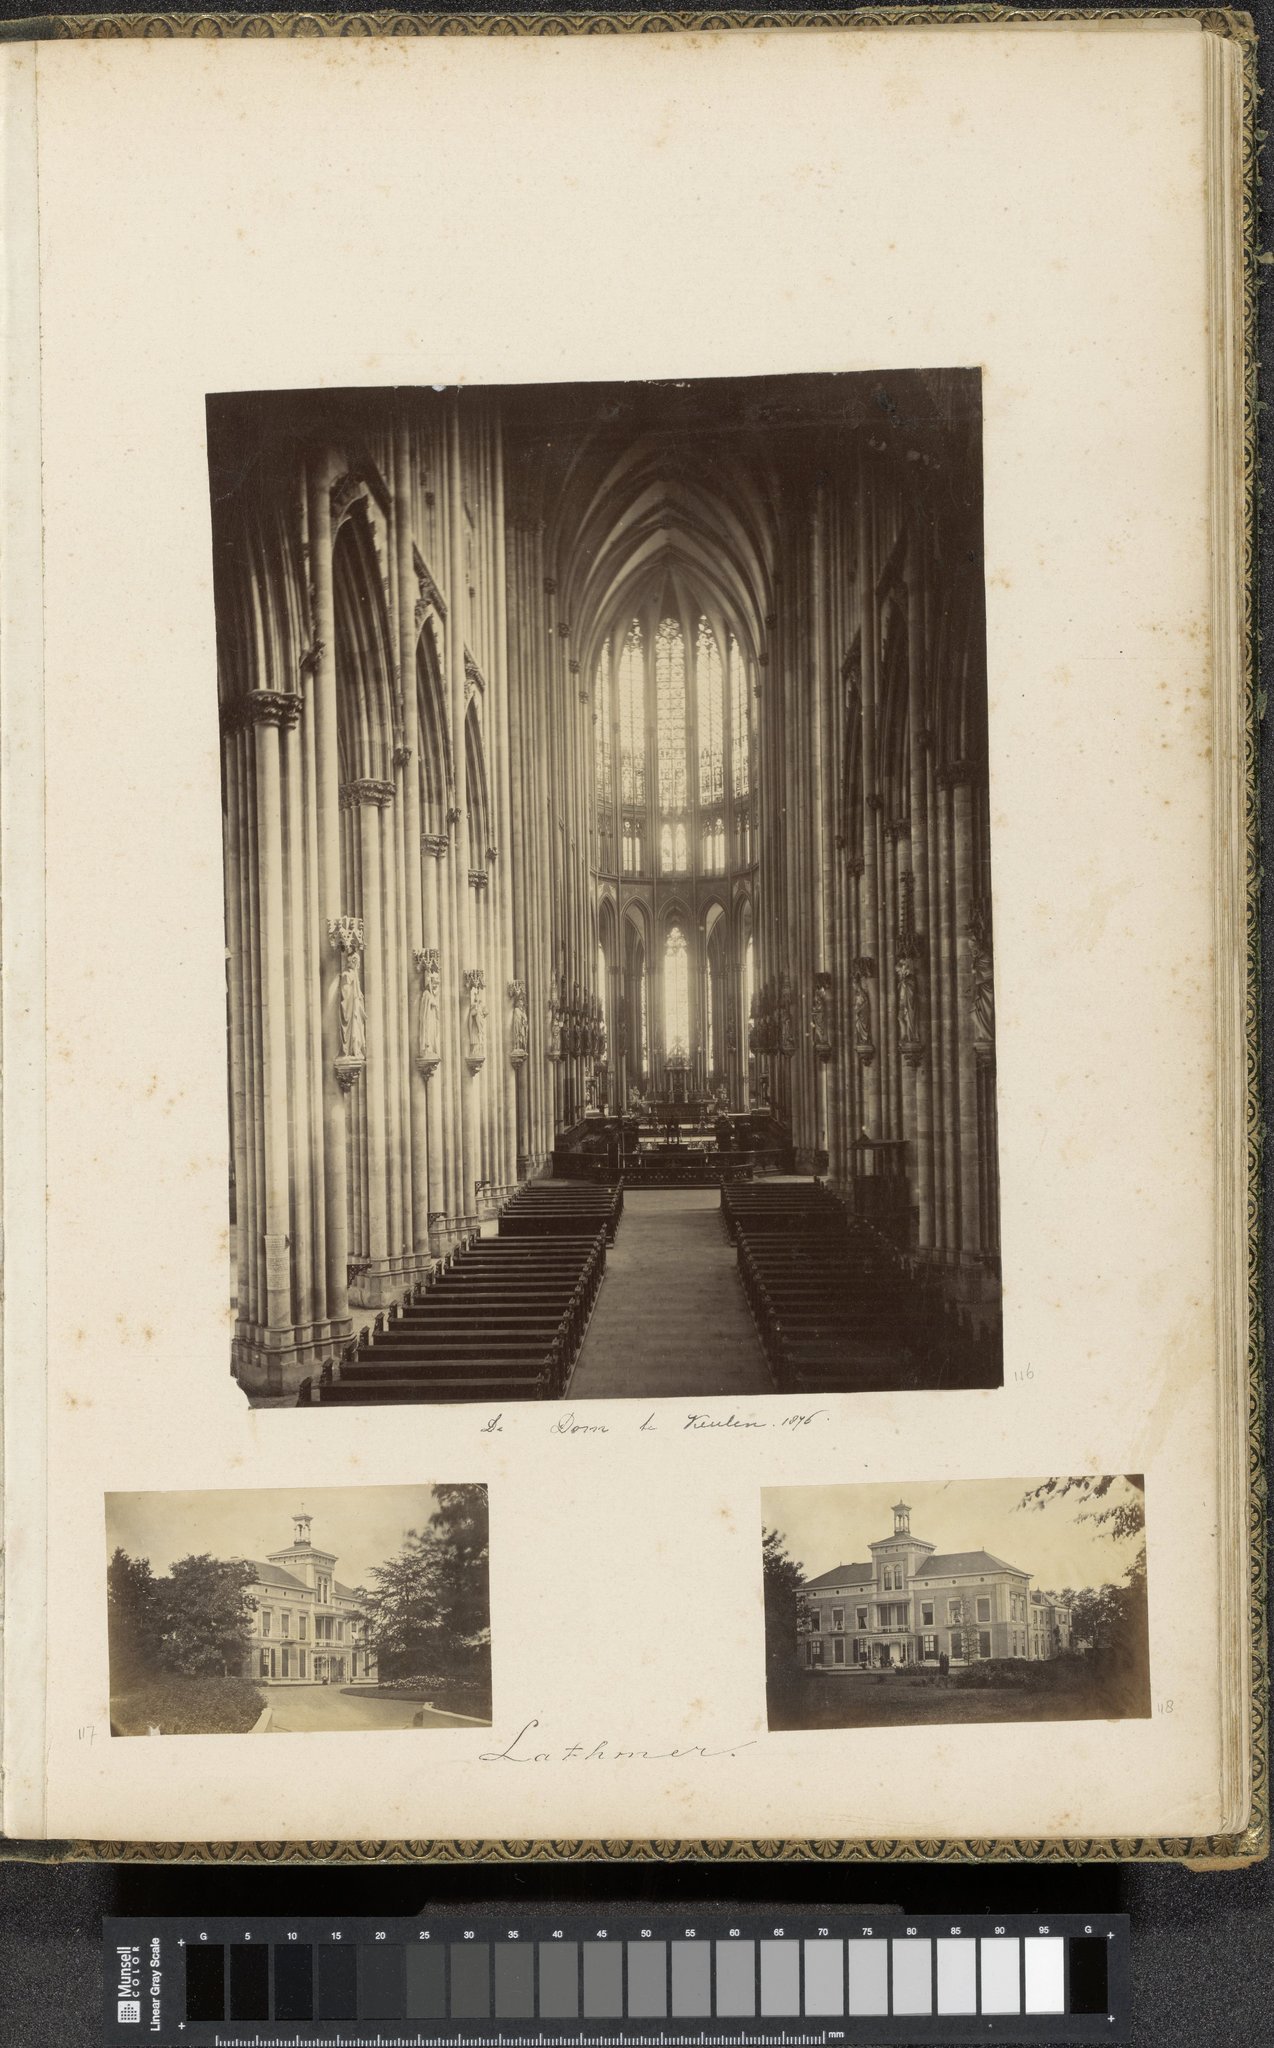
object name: album leaf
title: Exterieur van landhuis De Lathmer in Wilp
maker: Anonymous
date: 1870-1880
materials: paper, photographic support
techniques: albumen print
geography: wilp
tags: villa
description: Onderdeel van Fotoalbum van Robert Daniel Crommelin (1841-1907).